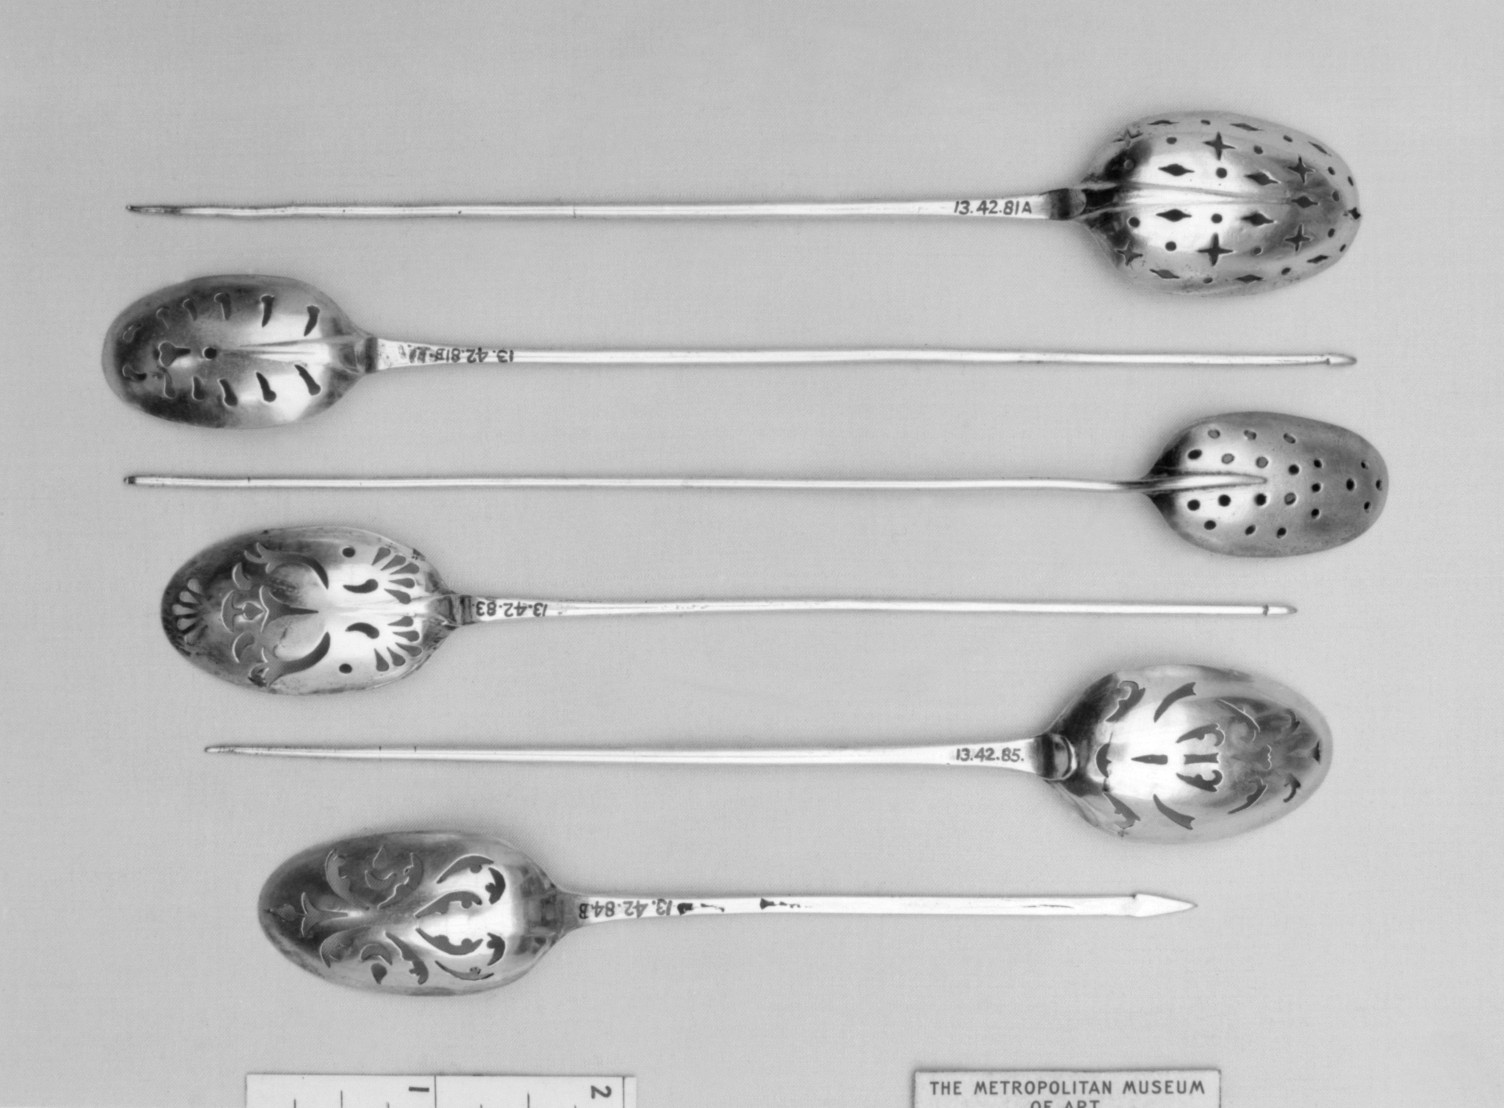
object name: strainer spoon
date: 1701-1800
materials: silver